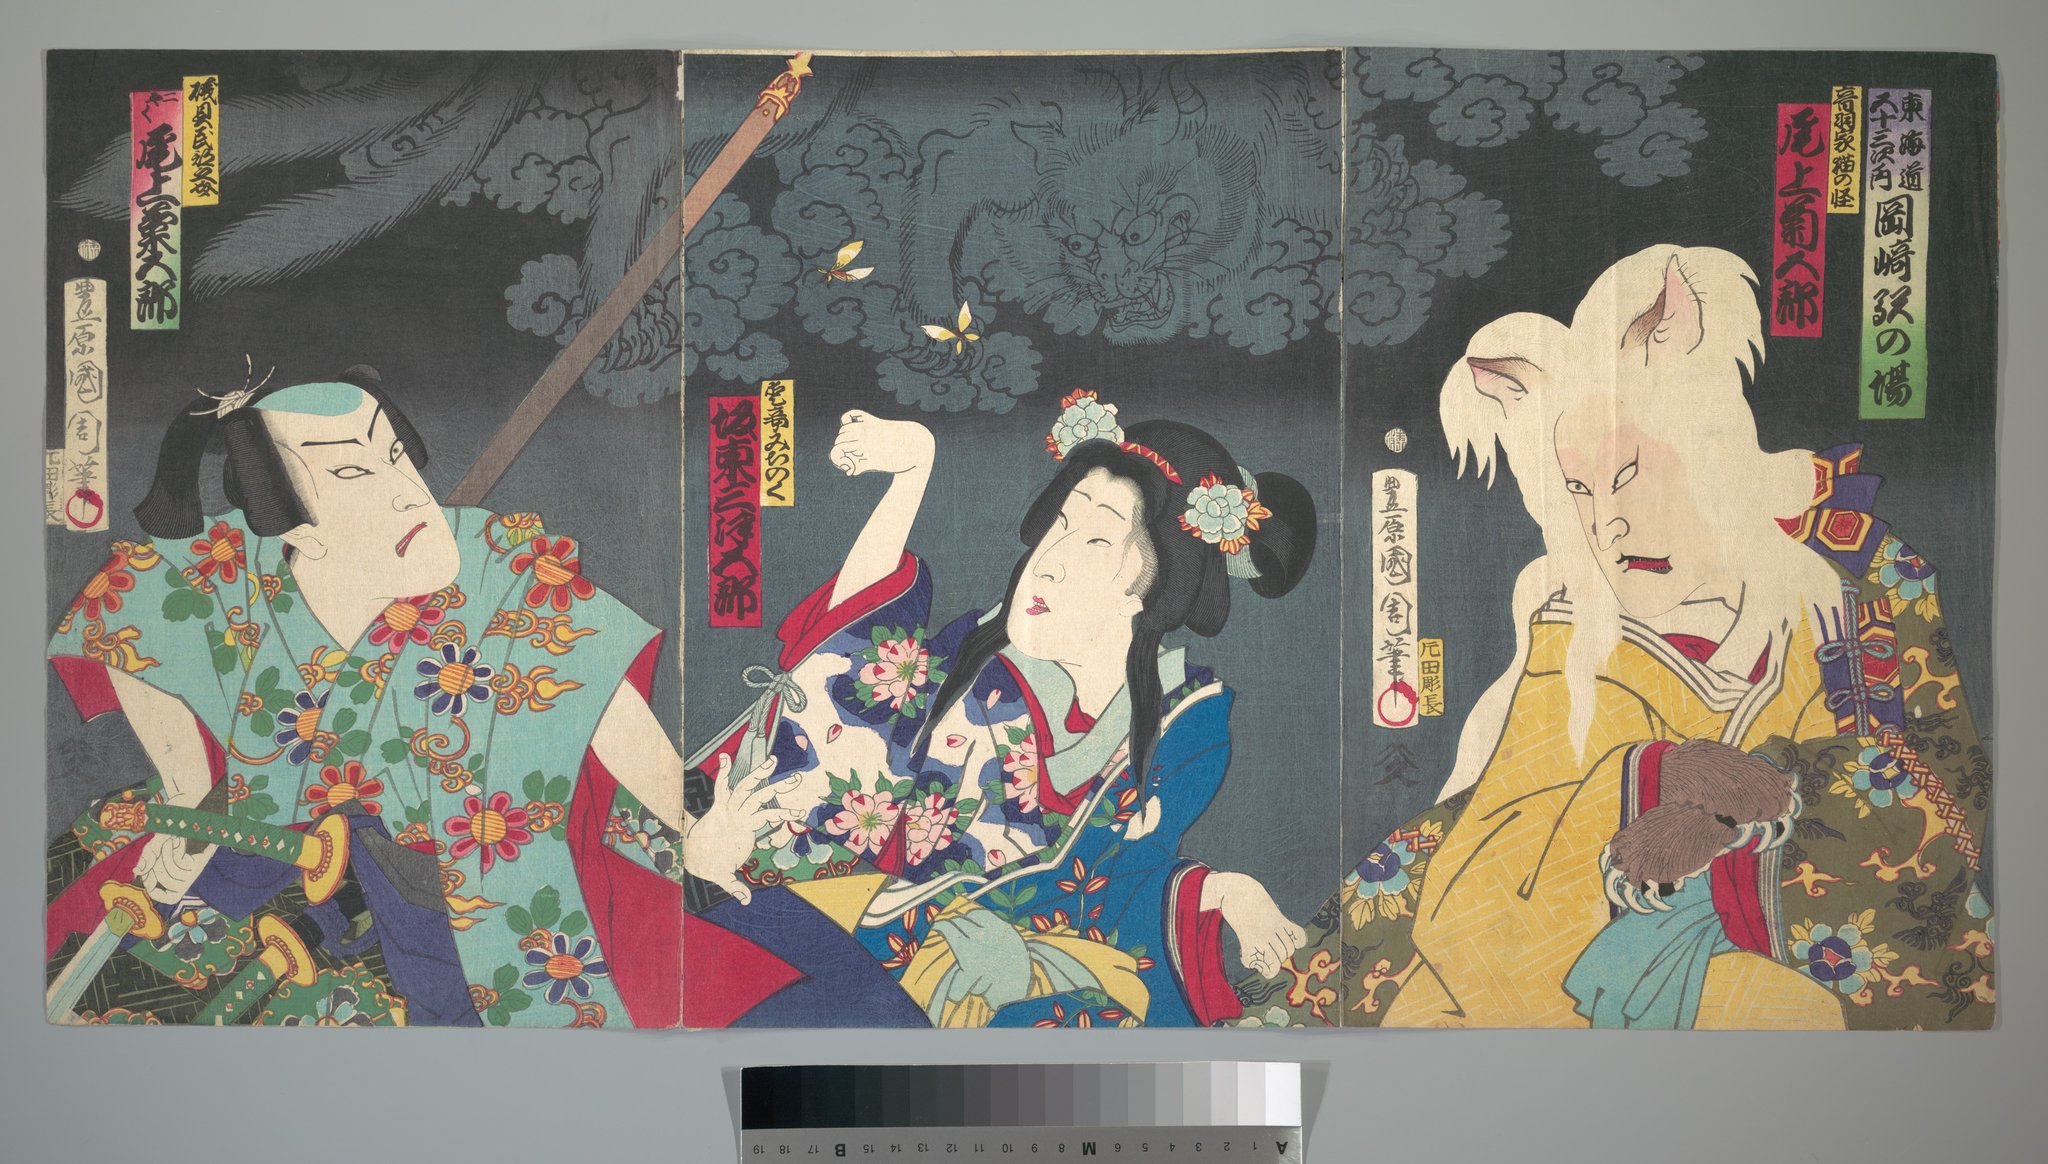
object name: print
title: Onoe Kikugorō V as Otowake Neko no ke (Right), Bandō Mitsugorō IV as Aishō Michinoku (Center), Onoe Kikugorō V as Isogai Mibunosuke (Left) in the Kabuki play Tōkai Kidan Nekomata Yashiki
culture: japanese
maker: toyohara kunichika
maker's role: artist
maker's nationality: japanese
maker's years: 1835-1900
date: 1870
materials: ink, paper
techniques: woodblock print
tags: men,women,actors